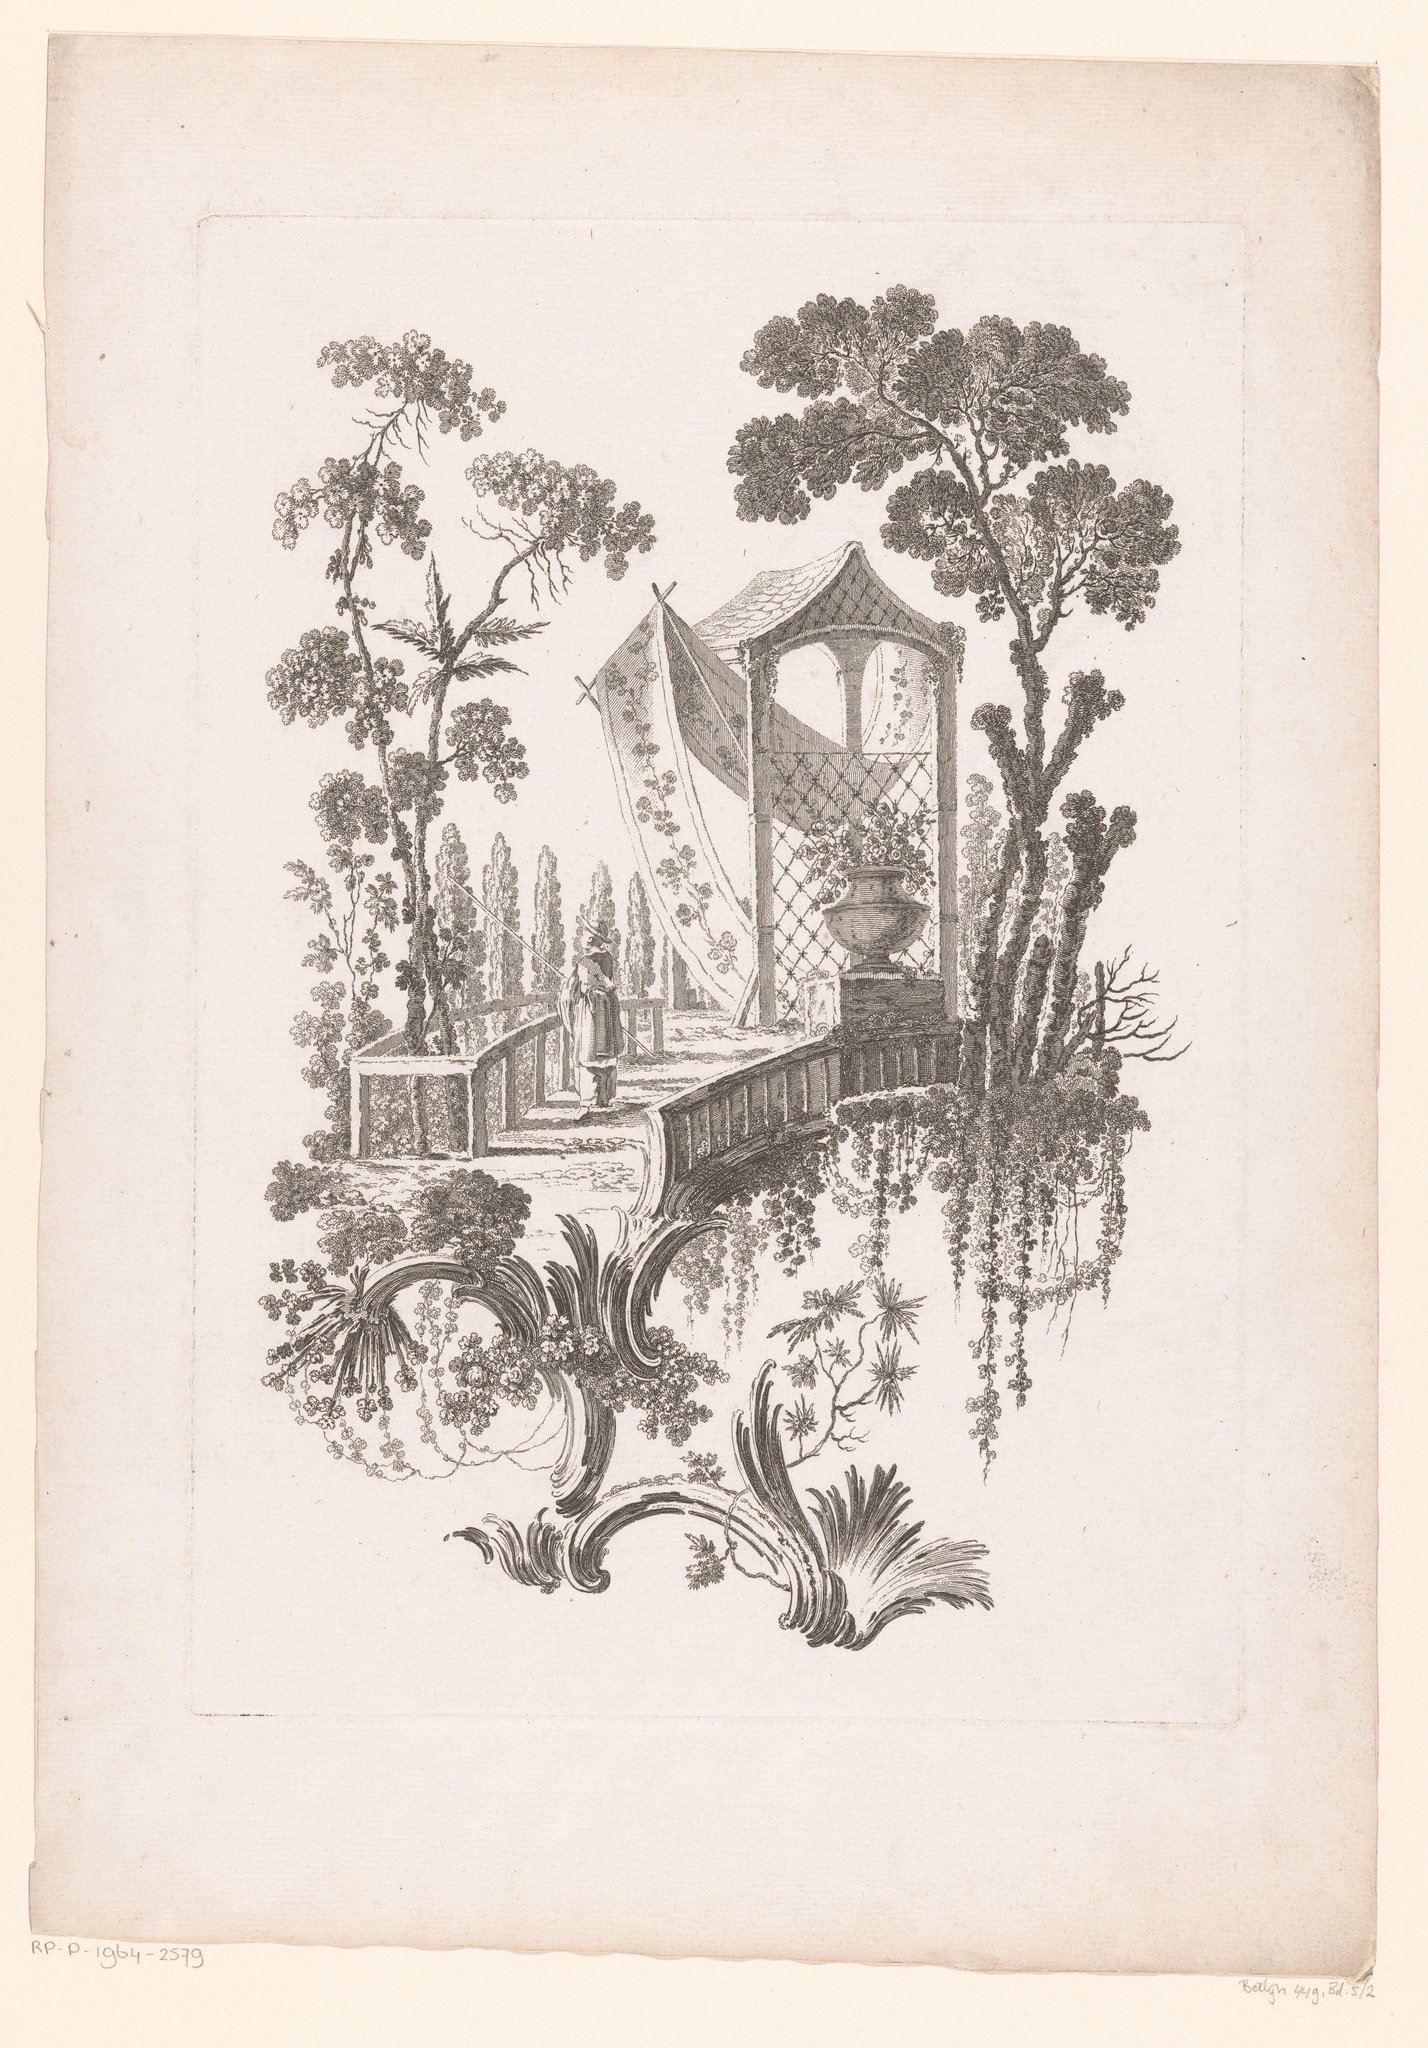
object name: ornament print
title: Man met stok op brug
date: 1755-1775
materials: paper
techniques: etching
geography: paris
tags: city-view, and landscape with man-made constructions - ii - ideal landscapes, standing figure, bridge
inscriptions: collector's mark: Lugt 2228, collector's mark: Lugt 2760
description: Een Chinese man op de rug gezien staat met een stok op een brug. Rechts van de brug staat een vaas met bloemen naast een overkapping met een banier.